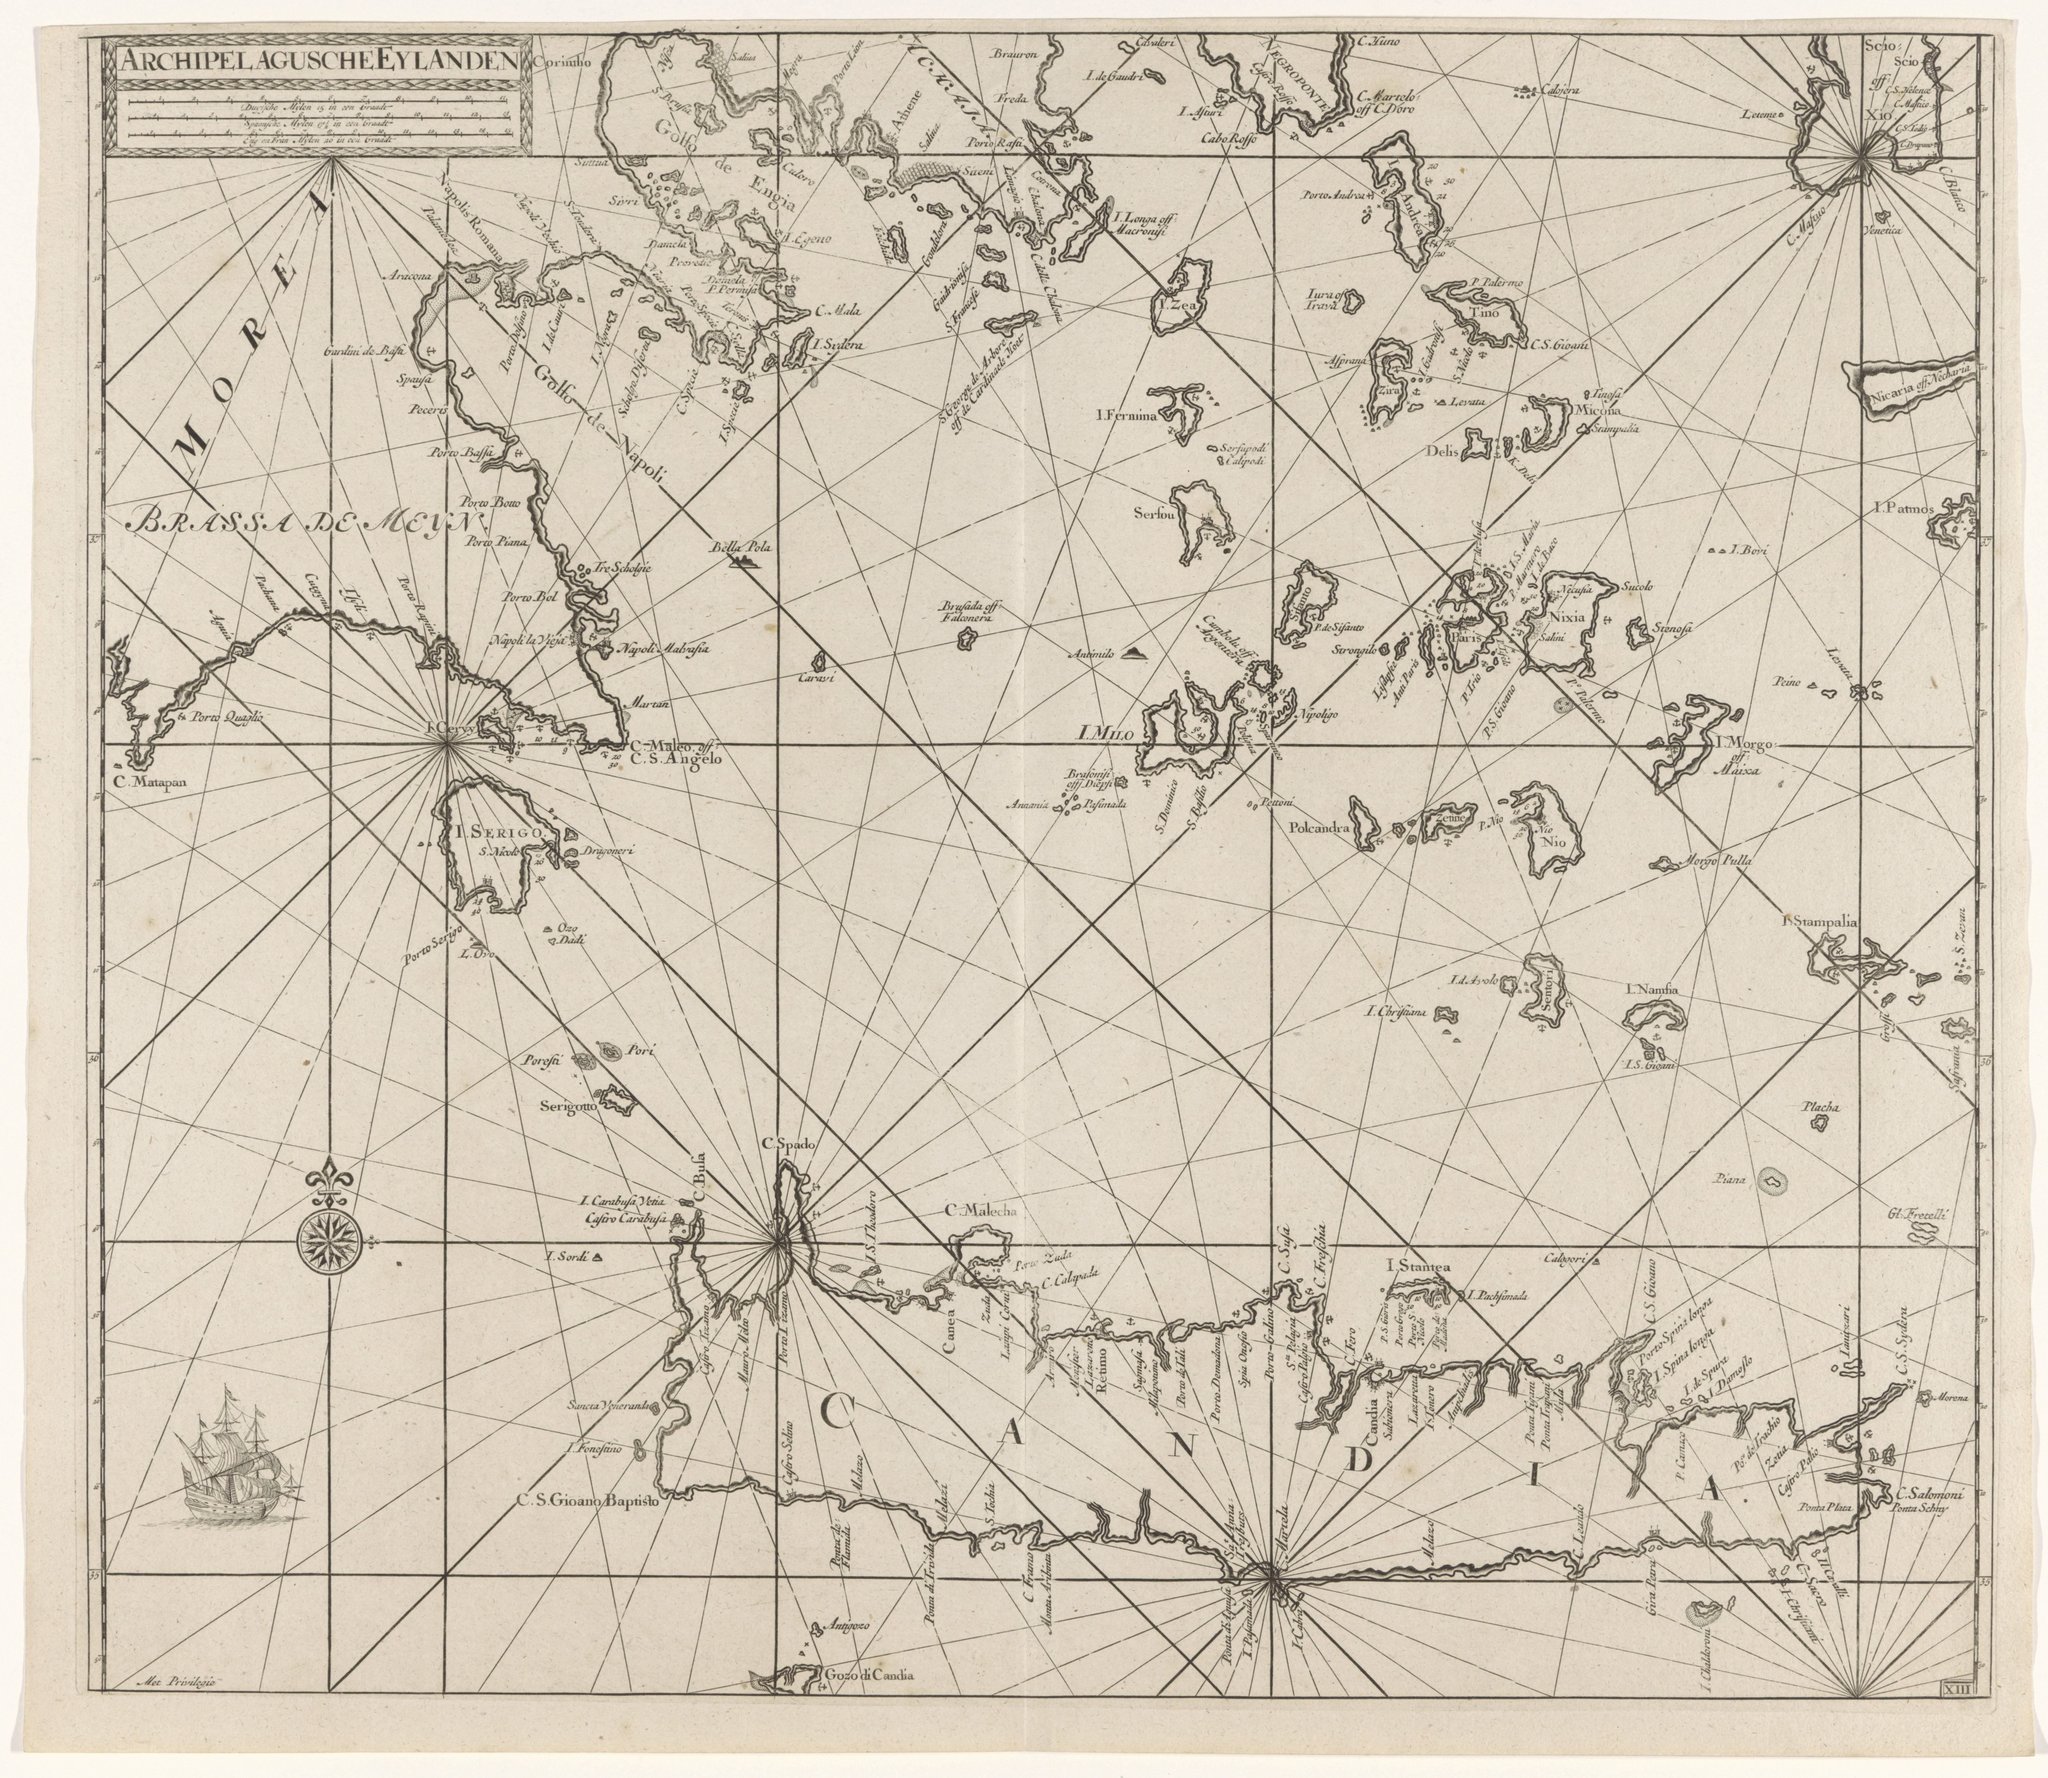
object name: print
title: Archipel Agusche Eylanden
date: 1682-1803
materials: paper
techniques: engraving, etching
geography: amsterdam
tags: sailing-ship, sailing-boat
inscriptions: collector's mark: Lugt 2228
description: Paskaart van het zuidelijk deel van de Egeïsche Zee met Kreta en met een kompasroos, het Noorden ligt boven. Linksboven de titel en de schaalverdeling, weergegeven in Duitse, Spaanse en Engelse of Franse mijlen (schaal: c. 1:700.000).